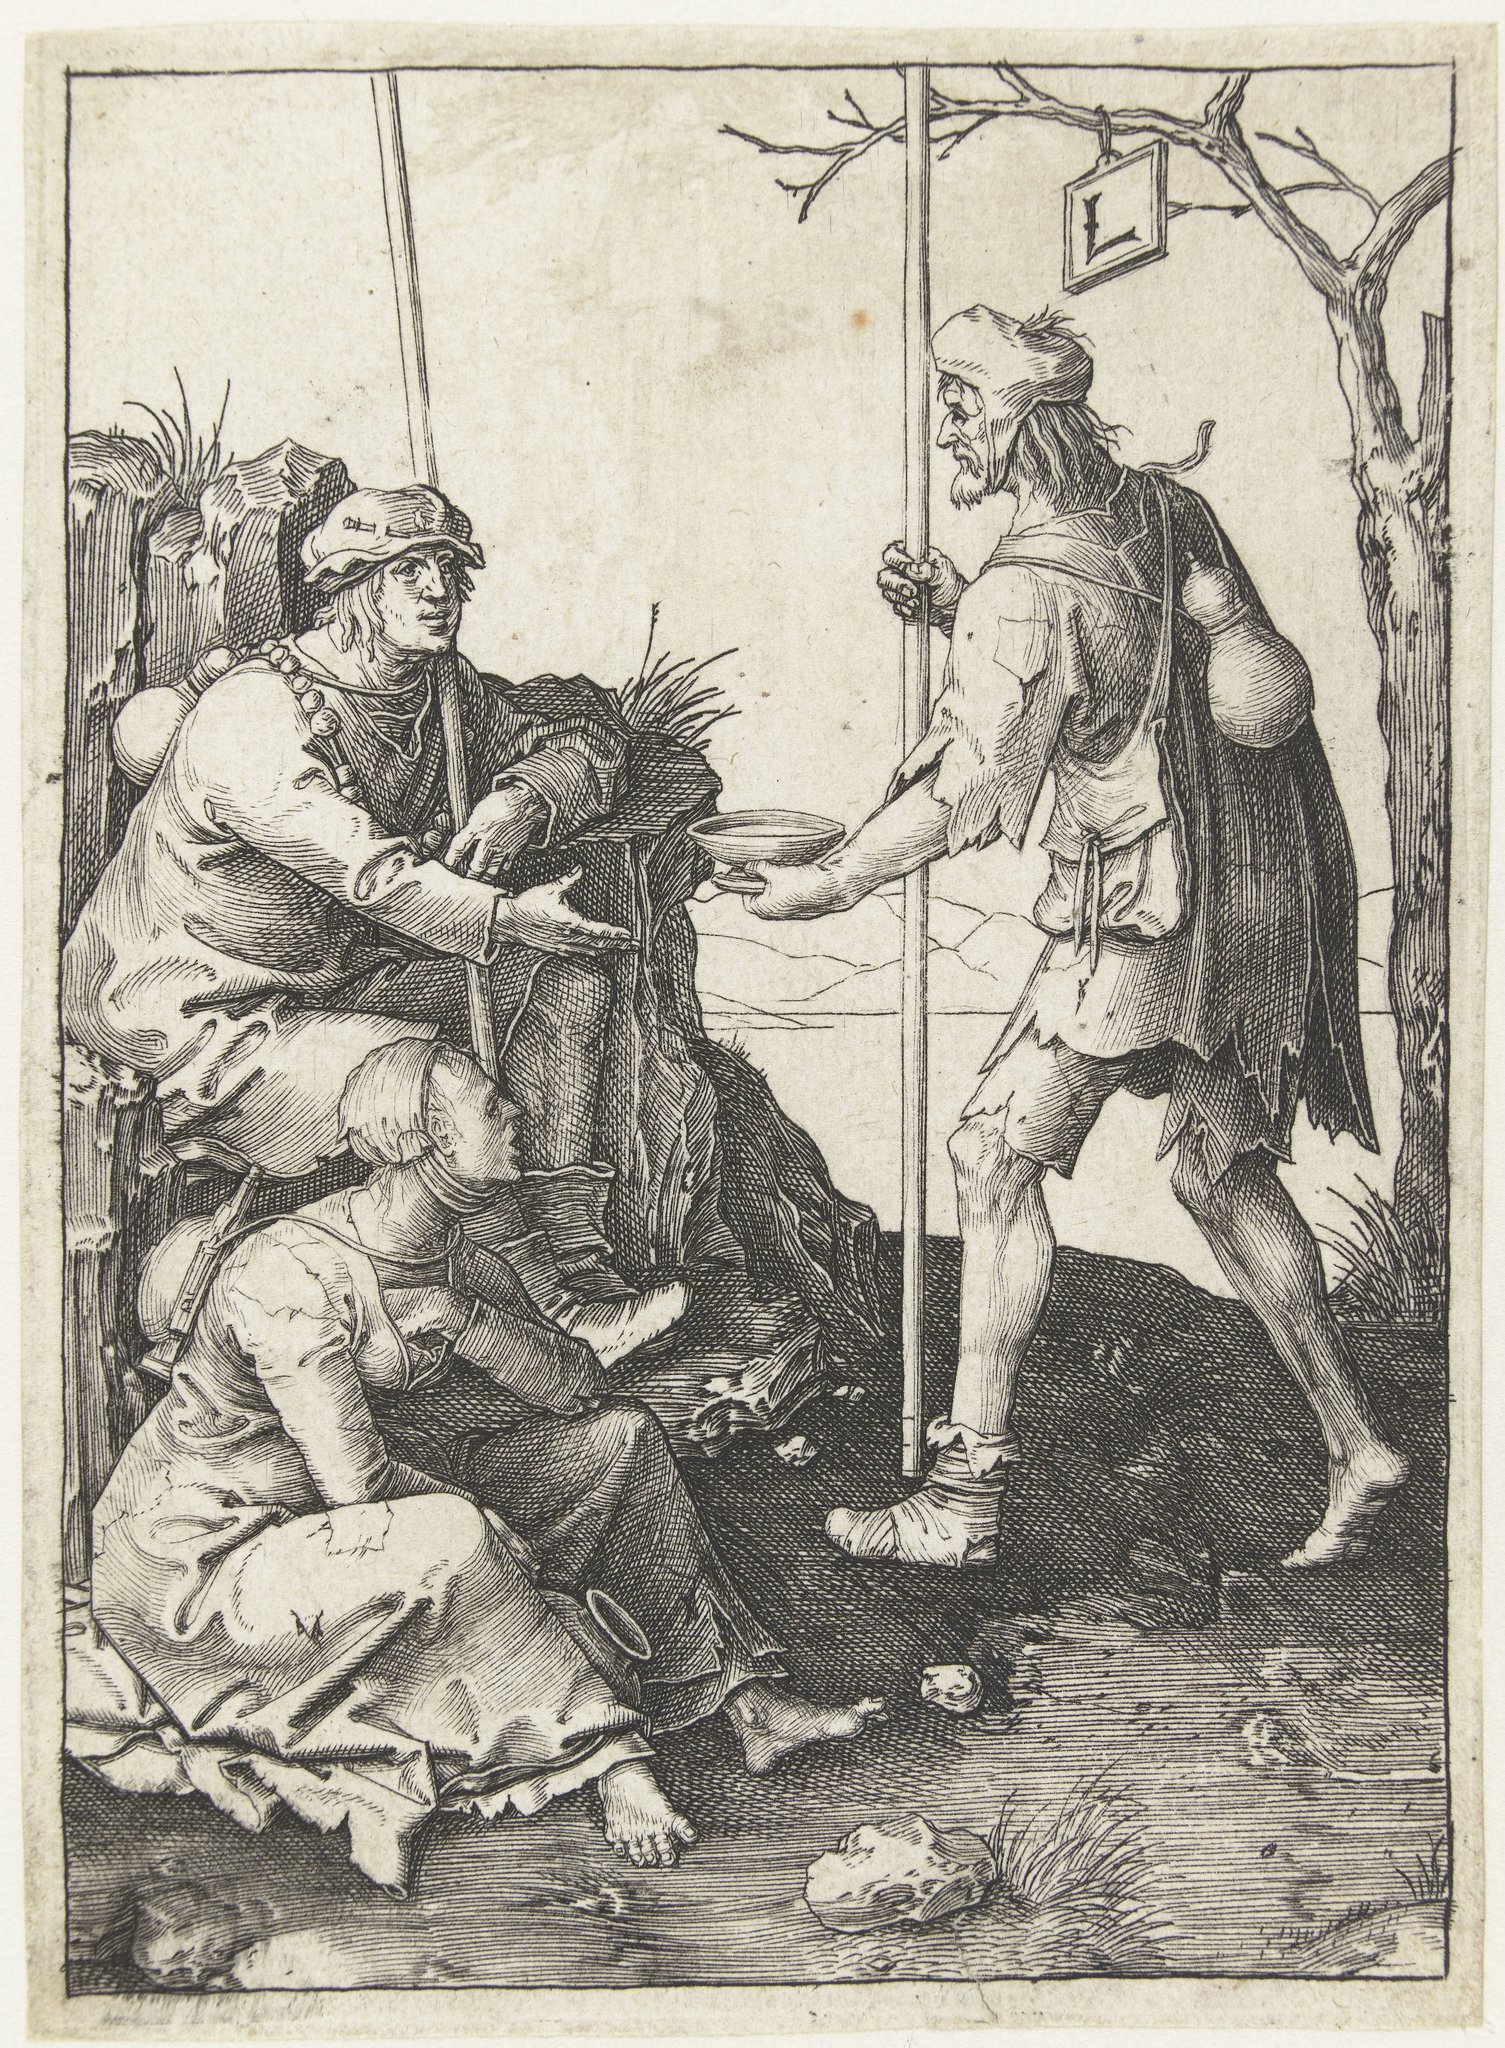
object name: print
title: De bedelaars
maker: lucas van leyden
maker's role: draughtsman, painter, print maker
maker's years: 1494-1533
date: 1507-1511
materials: paper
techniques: engraving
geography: low countries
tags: pilgrim(s), beggar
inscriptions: collector's mark: Lugt 240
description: Twee mannen met een pelgrimsstaf en fles, en een vrouw. Zij zouden bedelaars verkleed als pelgrims kunnen zijn, of zeer arme pelgrims.